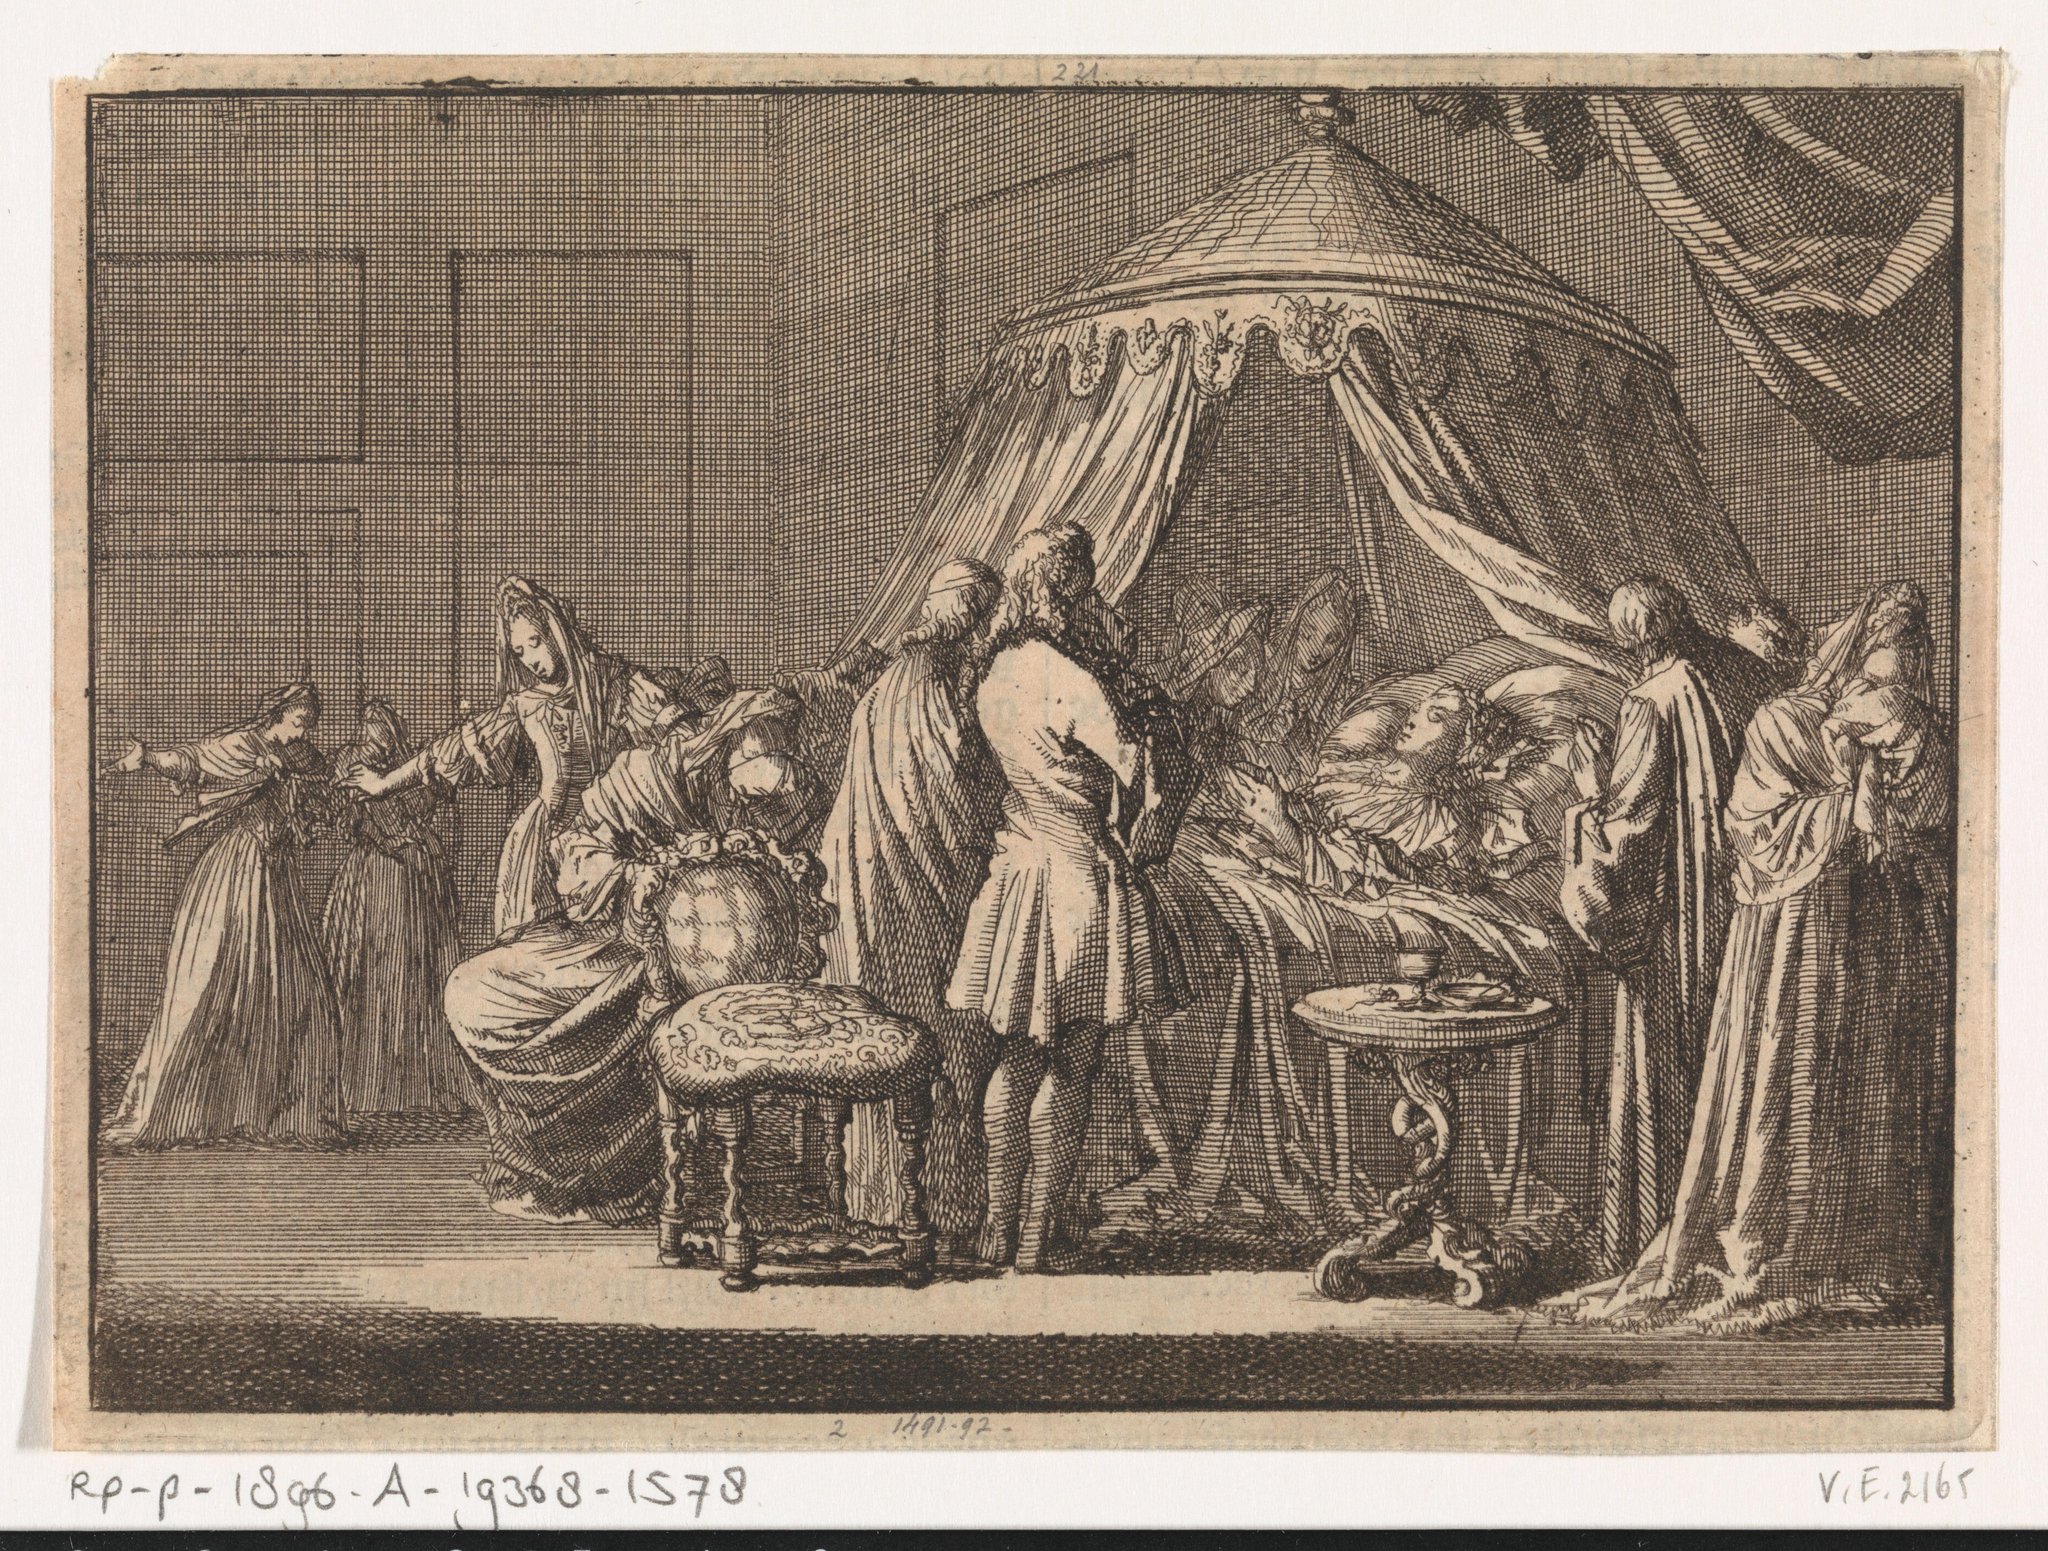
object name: print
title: Dood van Maria II Stuart, koningin van Engeland, 1695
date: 1698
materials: paper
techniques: etching, letterpress printing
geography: leiden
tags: london, maria ii stuart (koningin van engeland, schotland en ierland), deathbed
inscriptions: collector's mark: Lugt 2228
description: Illustratie uit: Gottfried, Johann Ludwig. Historische kronyck; vervattende een (...) beschrijvingh der aldergedenckwaerdigste geschiedenissen des weerelds, van den aenvangh der scheppingh tot (...) 1576 (2 delen). Leiden: Pieter van der Aa, 1698, dl. II, p. 1491.